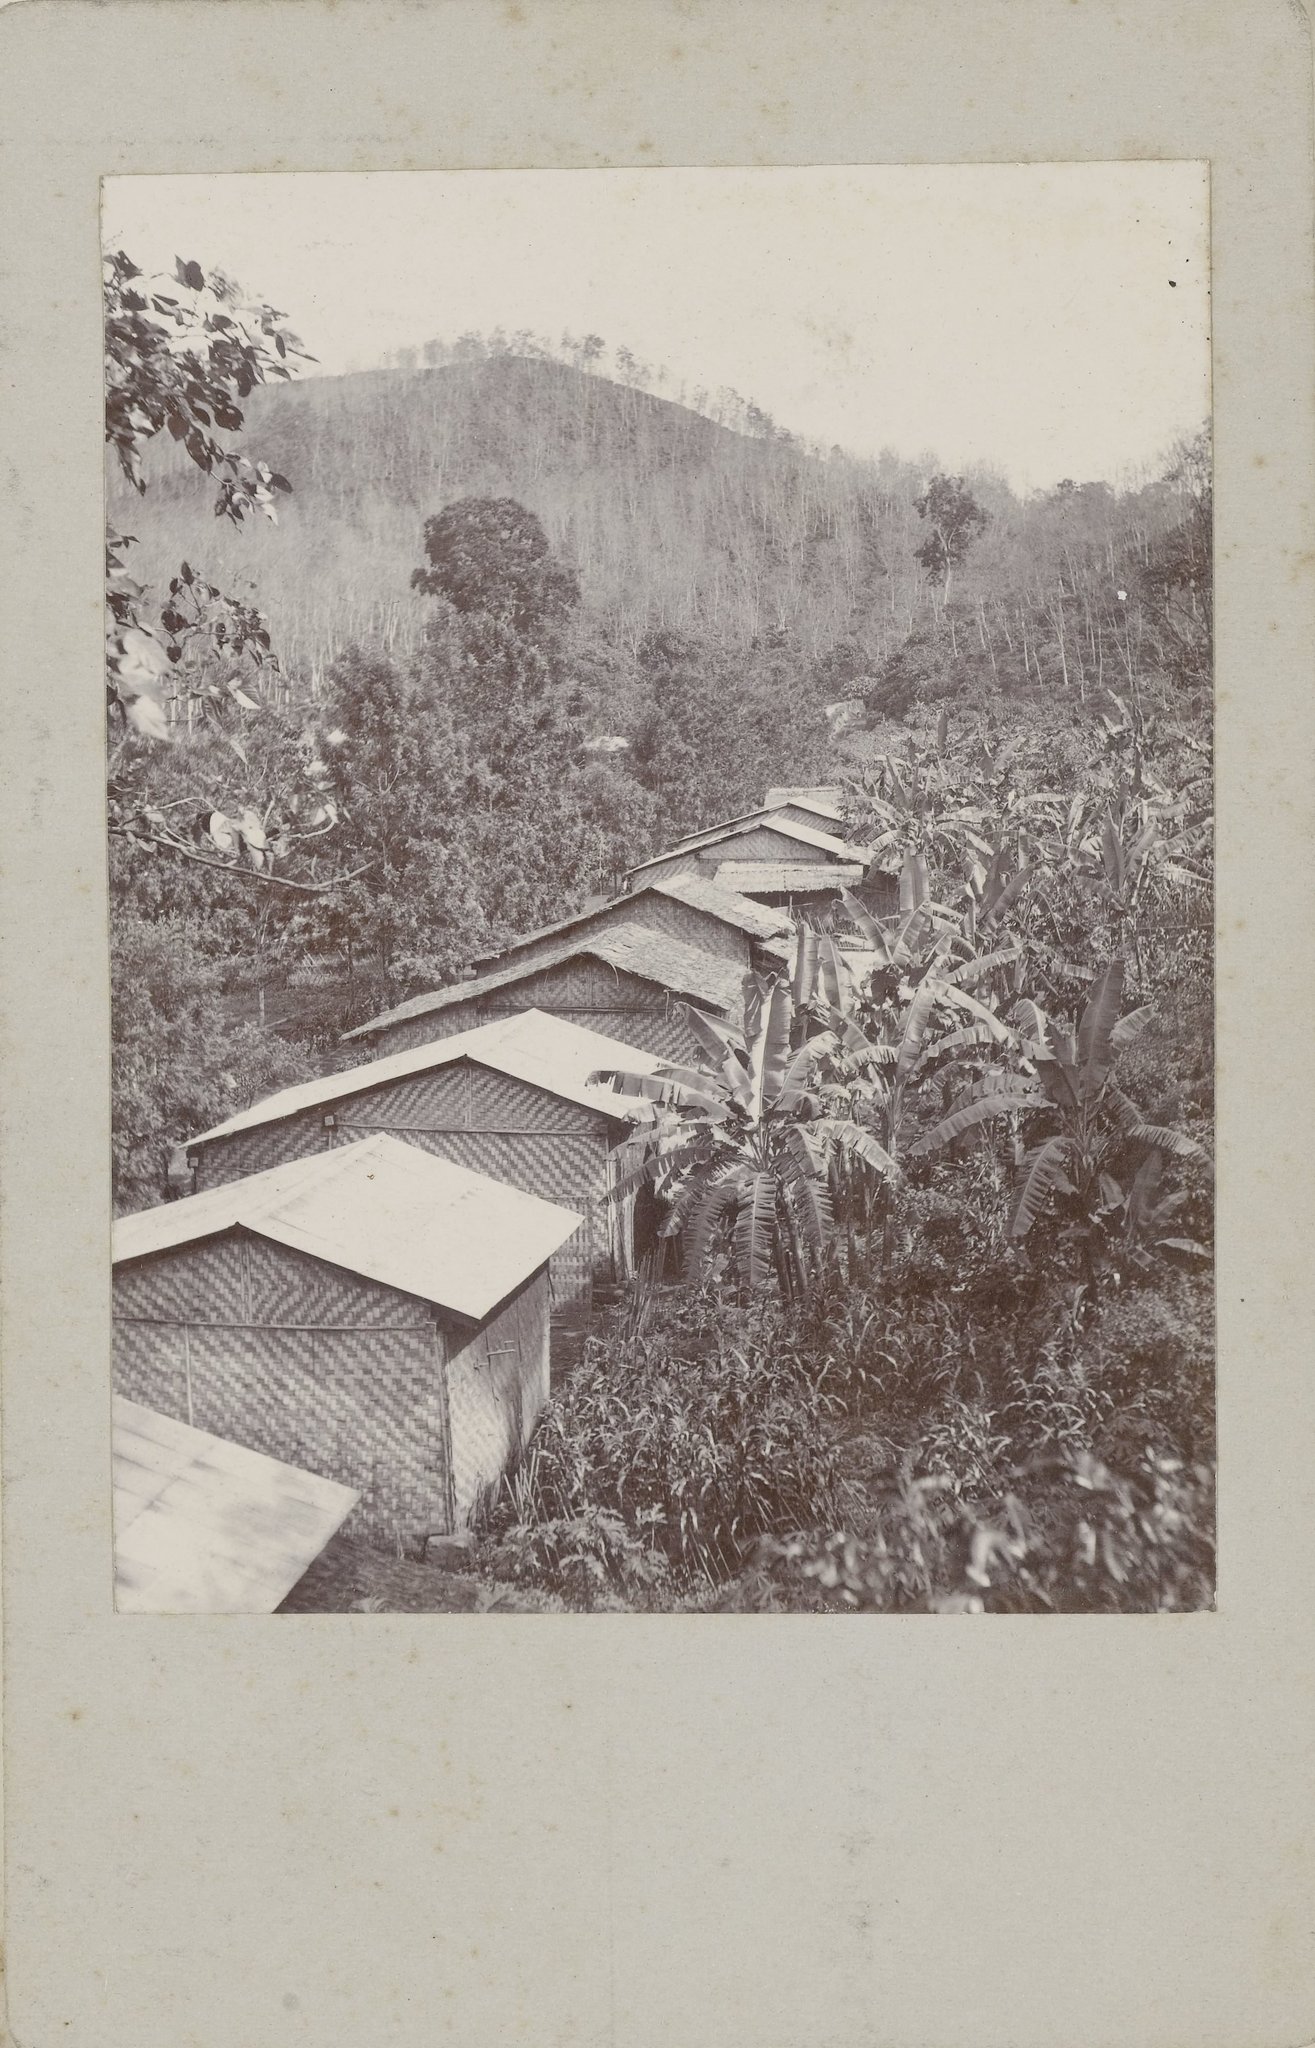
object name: photograph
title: Het fabrieksterrein van Silo Sanen in Indoensië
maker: Anonymous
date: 1890-1910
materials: cardboard, photographic support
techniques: gelatin silver print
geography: indonesia